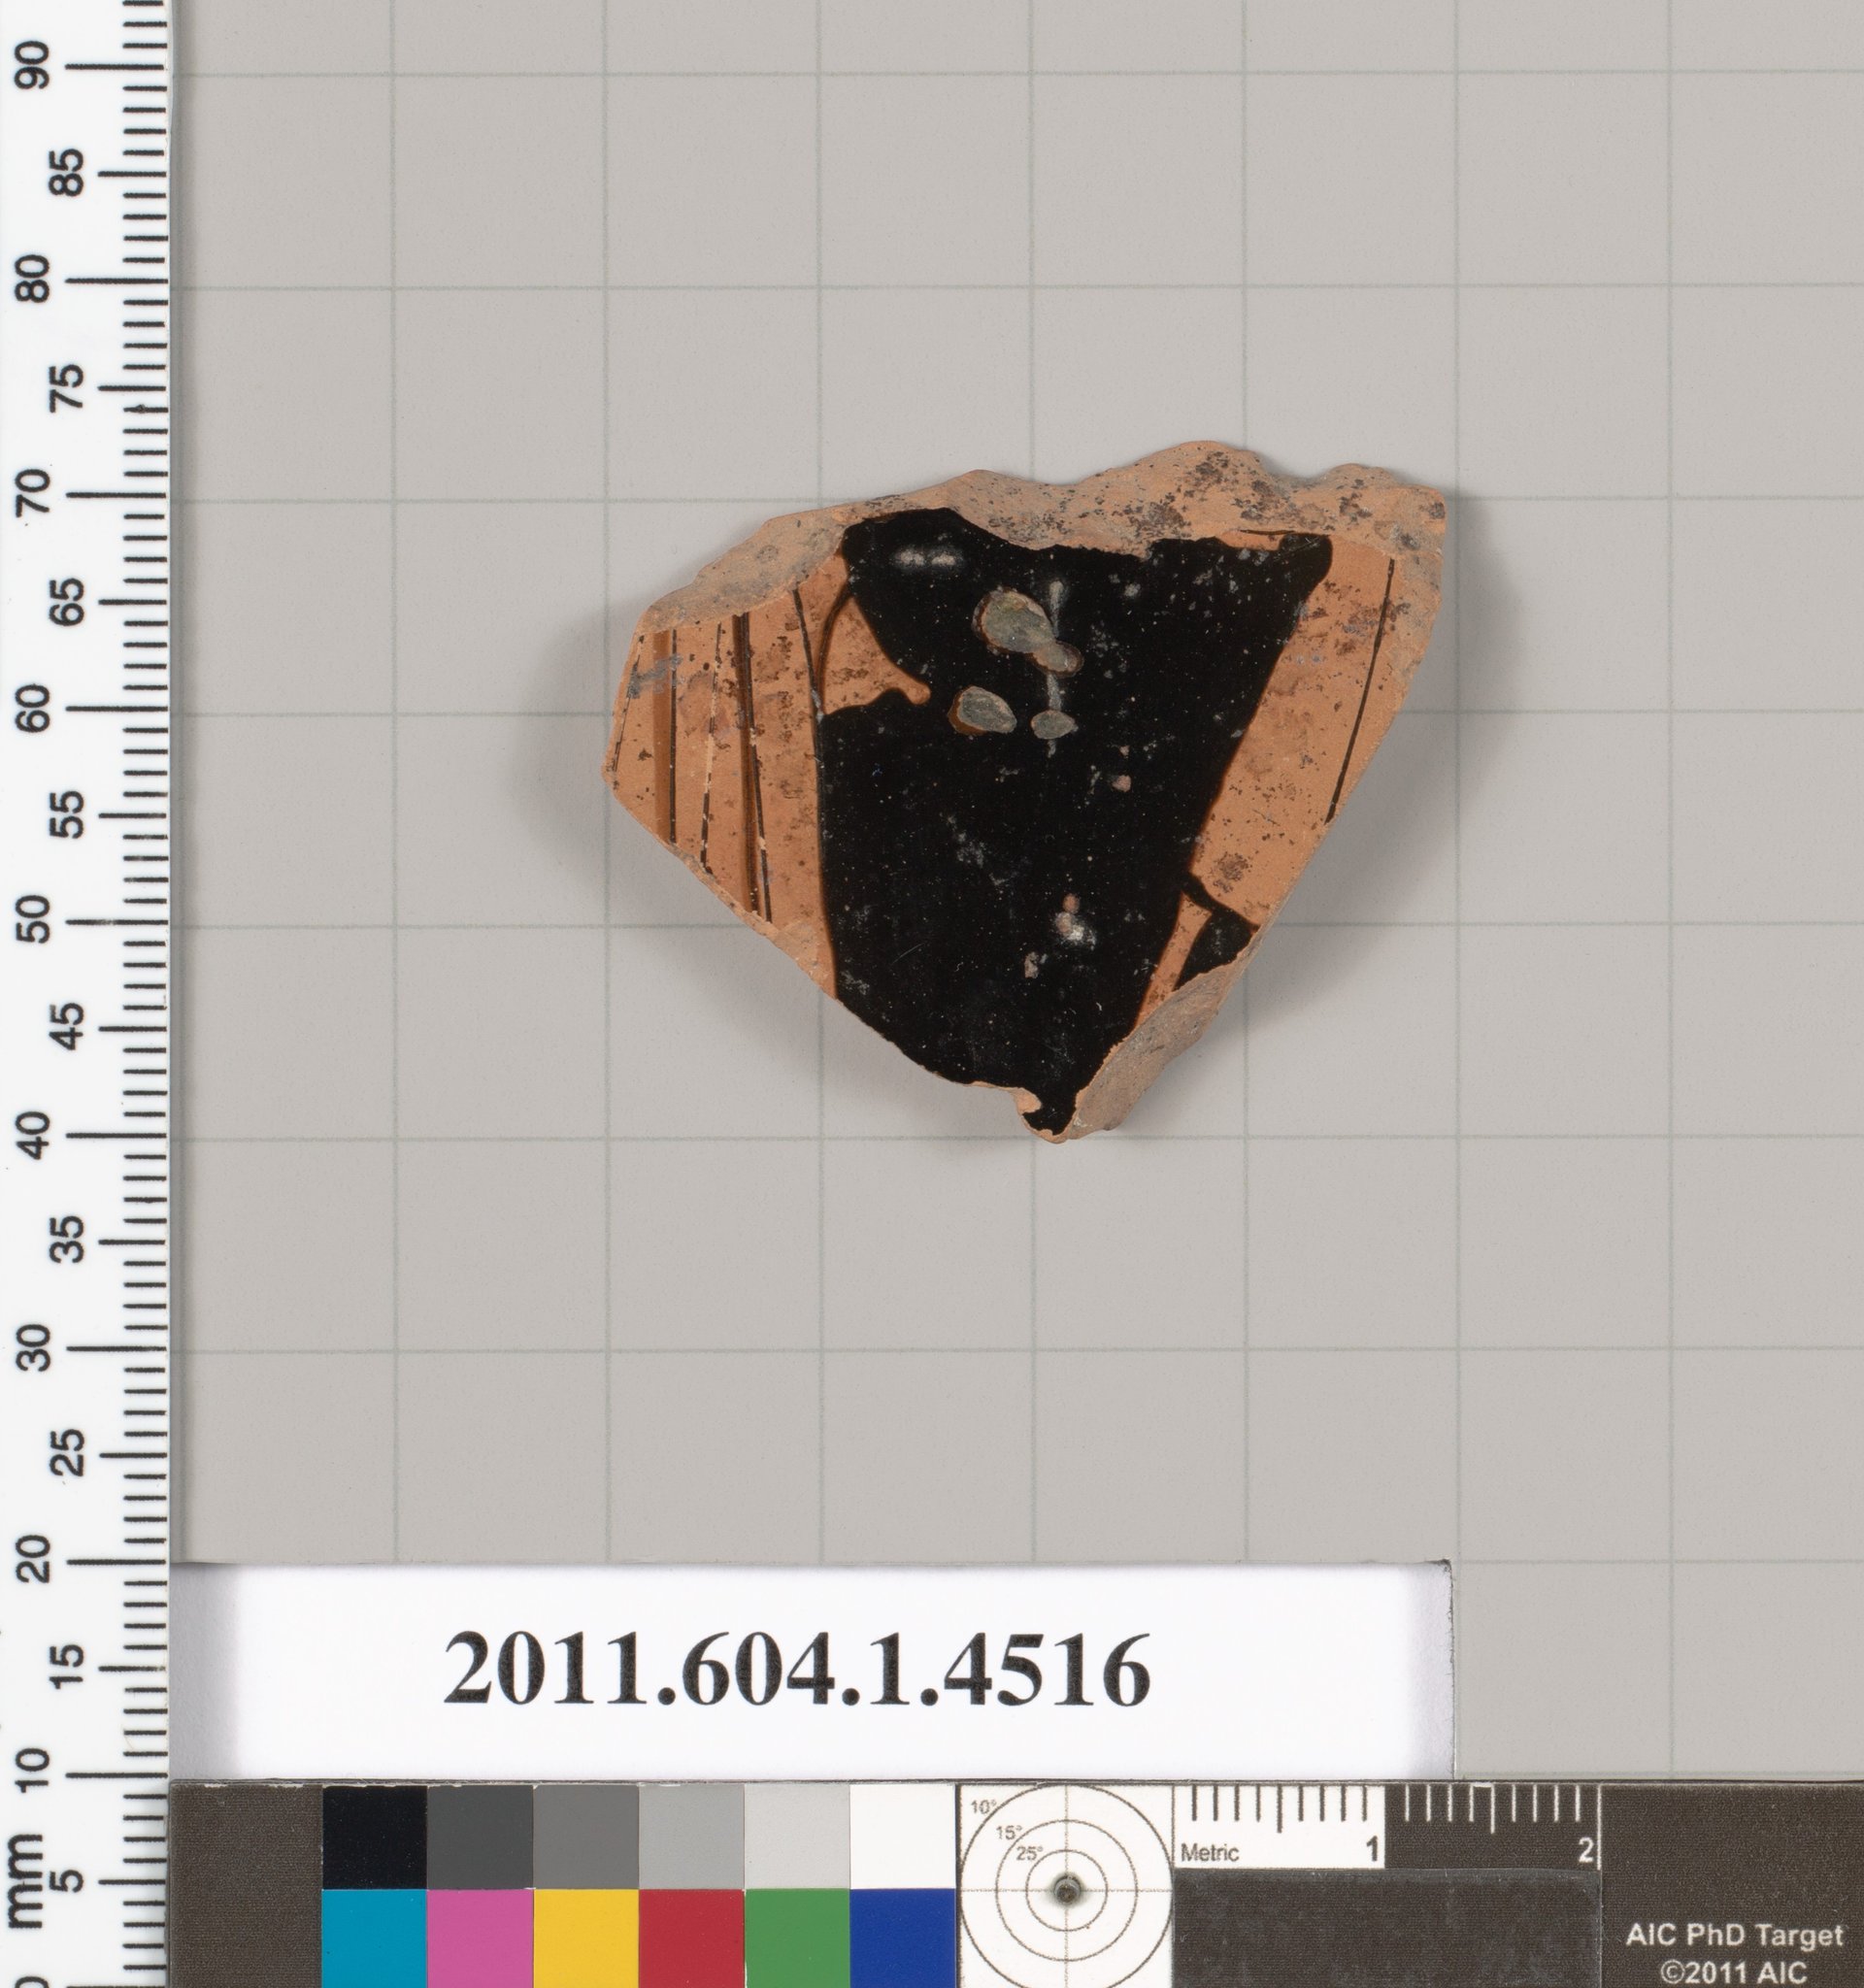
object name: kylix fragment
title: Terracotta fragment of a kylix (drinking cup)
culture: greek, attic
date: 475-451 BCE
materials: terracotta